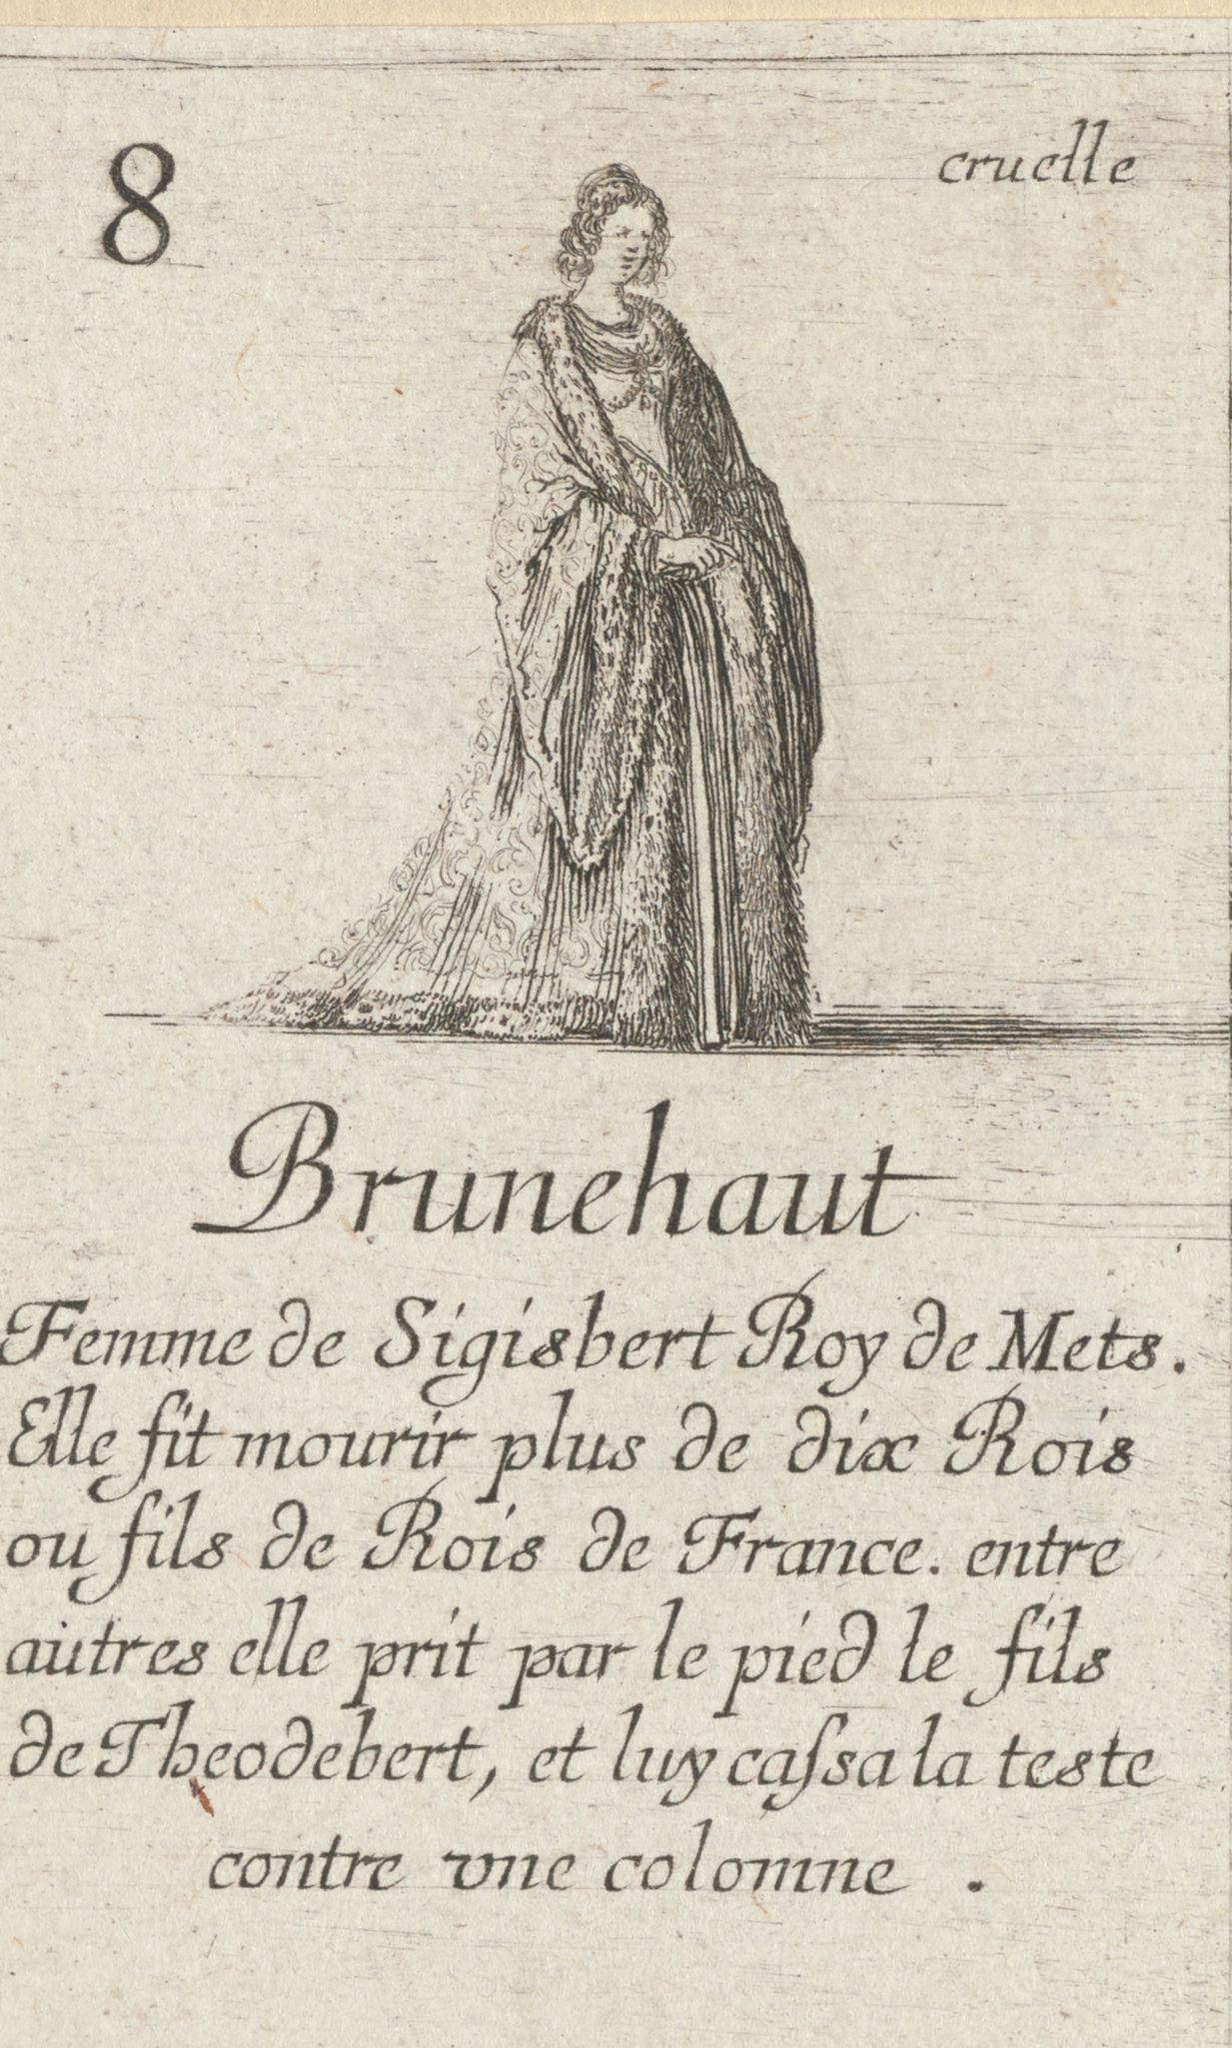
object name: playing card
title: Brunehaut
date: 1620-1664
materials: paper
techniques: etching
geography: paris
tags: ruler, sovereign - bb - female ruler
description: Deze prent maakt deel uit van een kaartspel met 52 kaarten met voorstellingen van beroemde koninginnen. De serie is uitgedacht door Jean Desmarests de Saint-Sorlin in opdracht van Kardinaal Mazarin. Het kaartspel werd gemaakt voor de jonge Lodewijk XIV, samen met het Jeu des Fables, Jeu de la Géographie en Jeu des Rois de France.